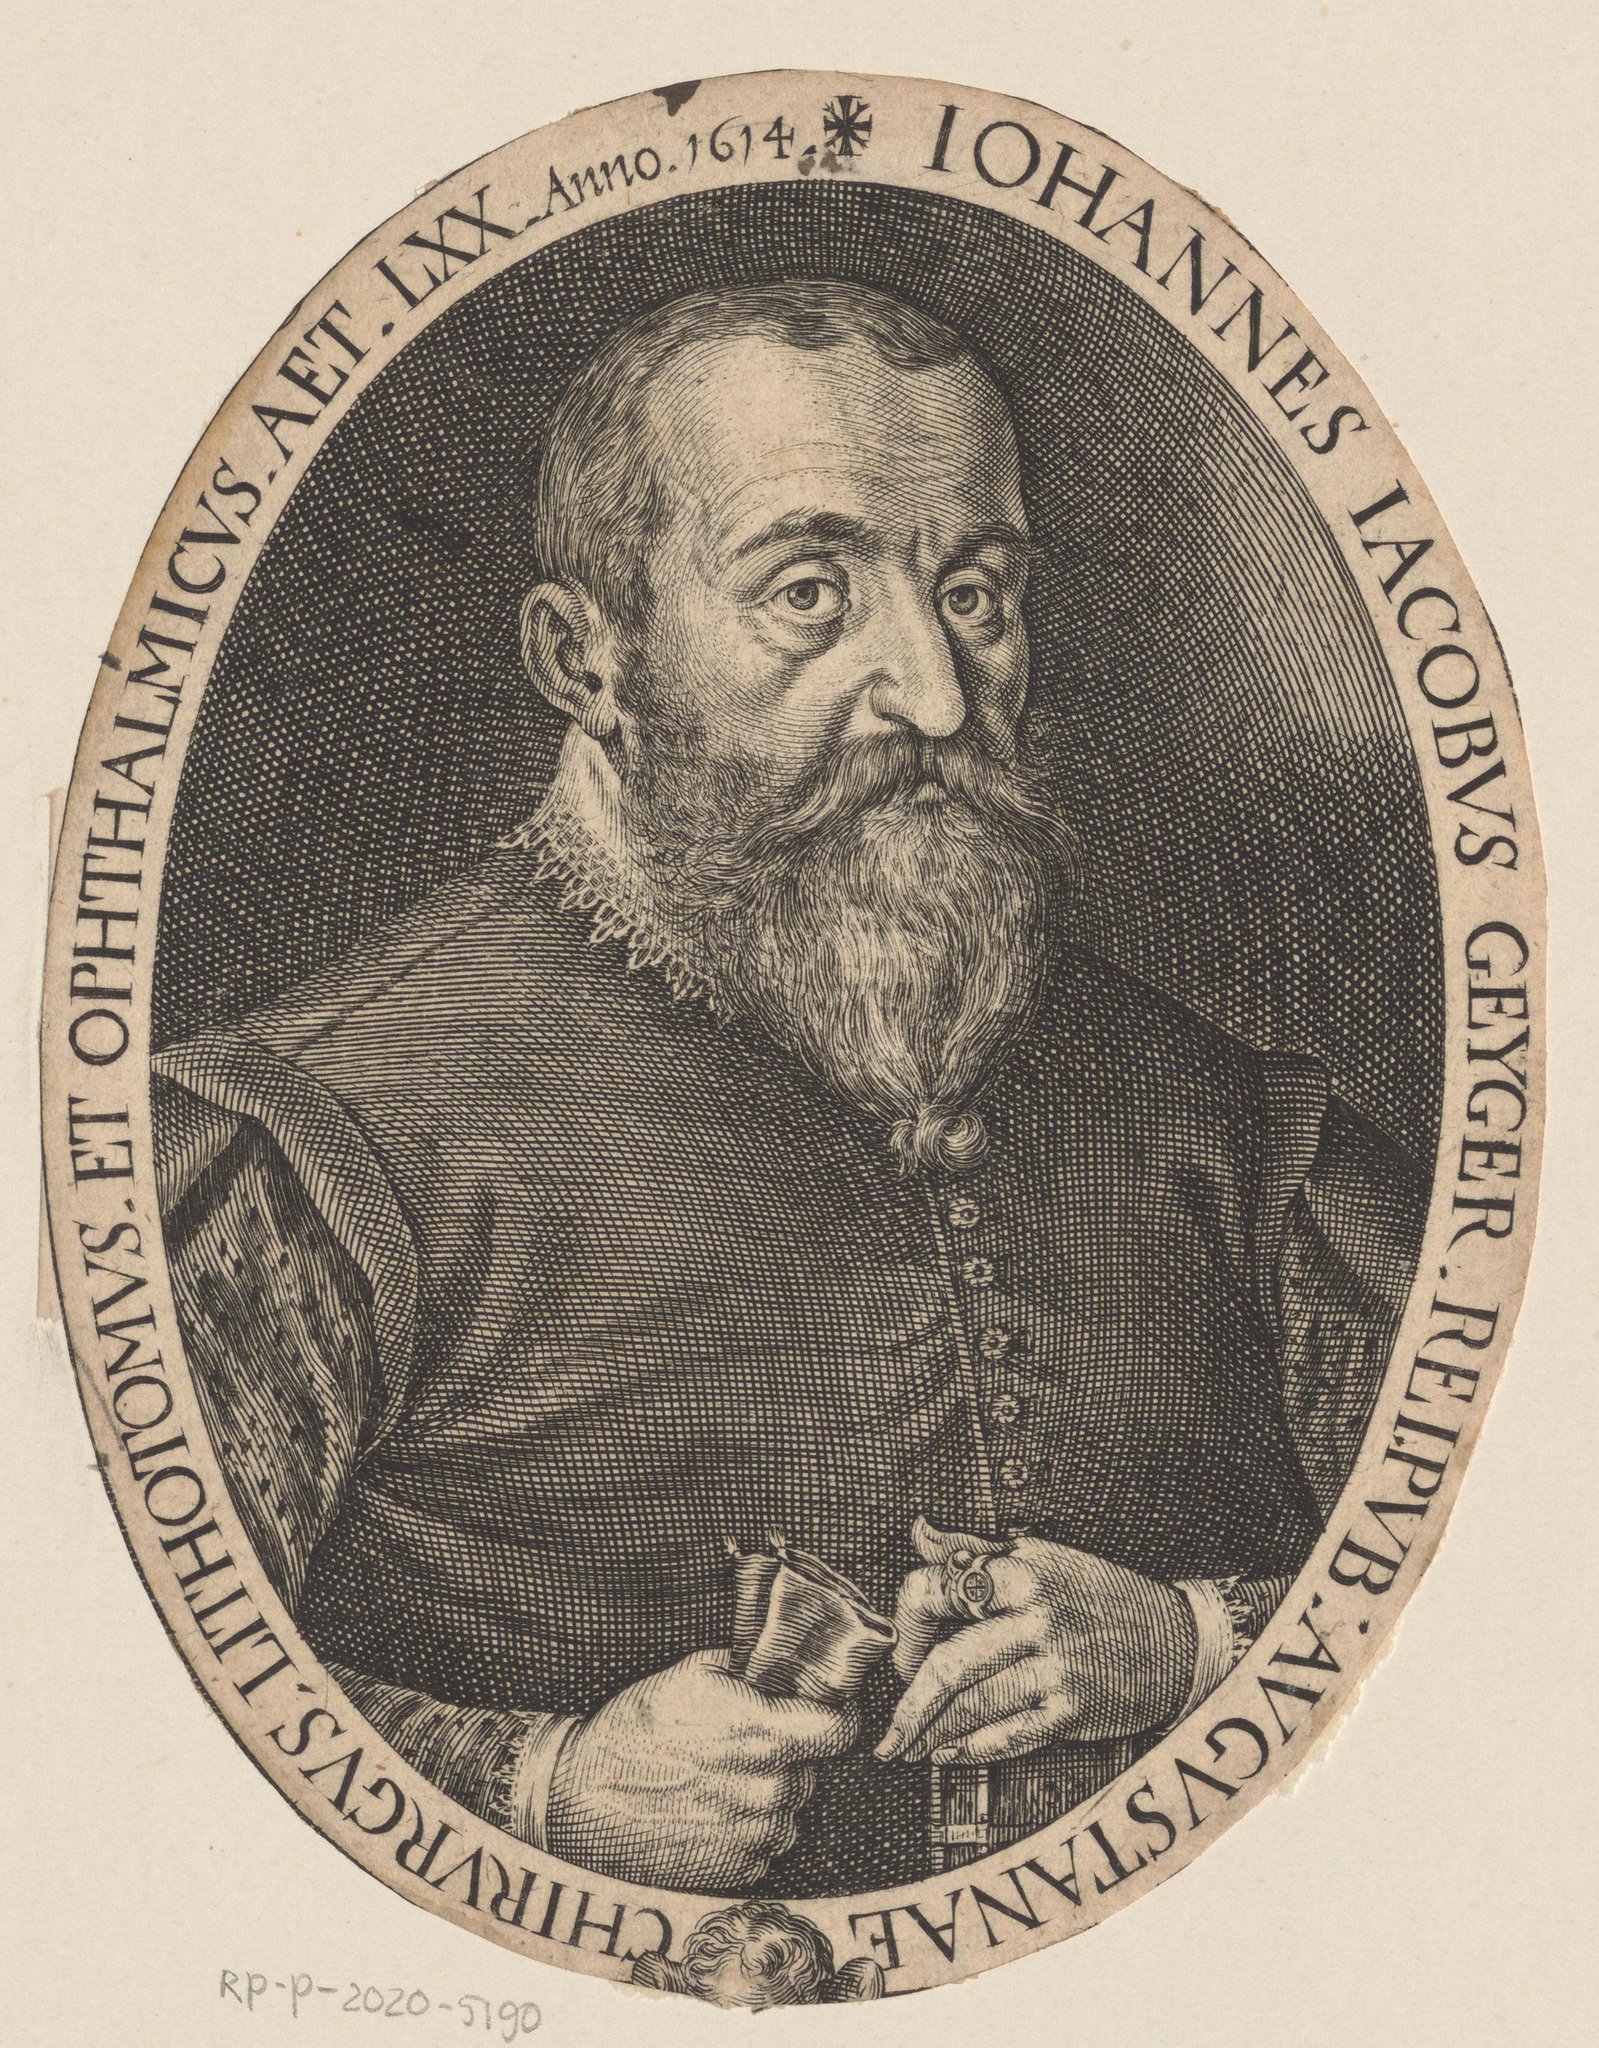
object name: print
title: Portret van Johann Jacob Geyger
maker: raphael custos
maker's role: print maker, publisher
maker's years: 1590-1664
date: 1614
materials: paper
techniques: engraving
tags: historical persons, lawyer, attorney at law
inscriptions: date